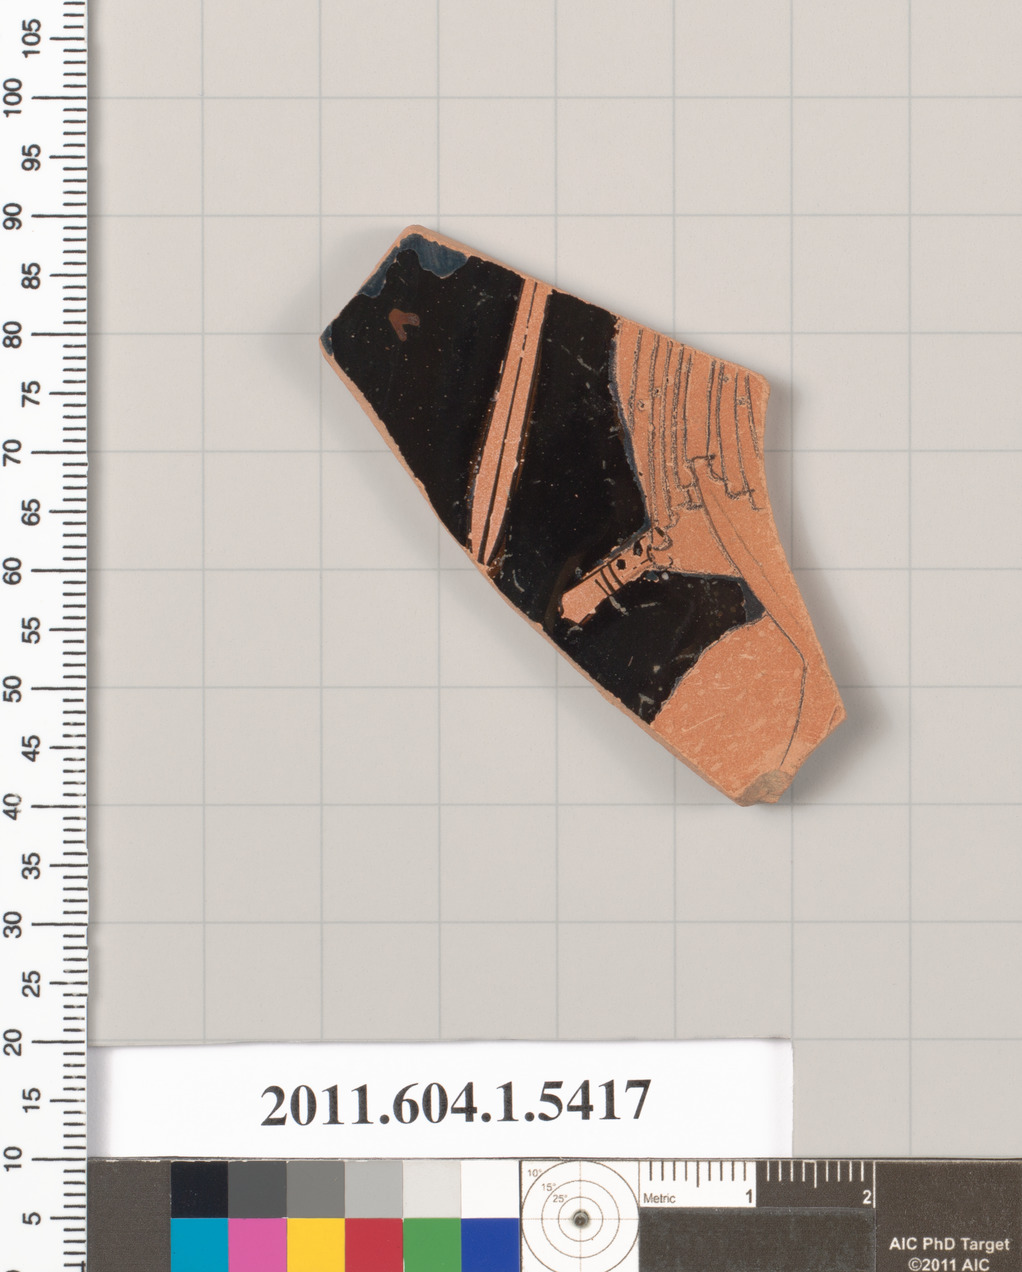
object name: kylix fragment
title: Terracotta fragment of a kylix (drinking cup)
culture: greek, attic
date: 490-480 BCE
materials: terracotta